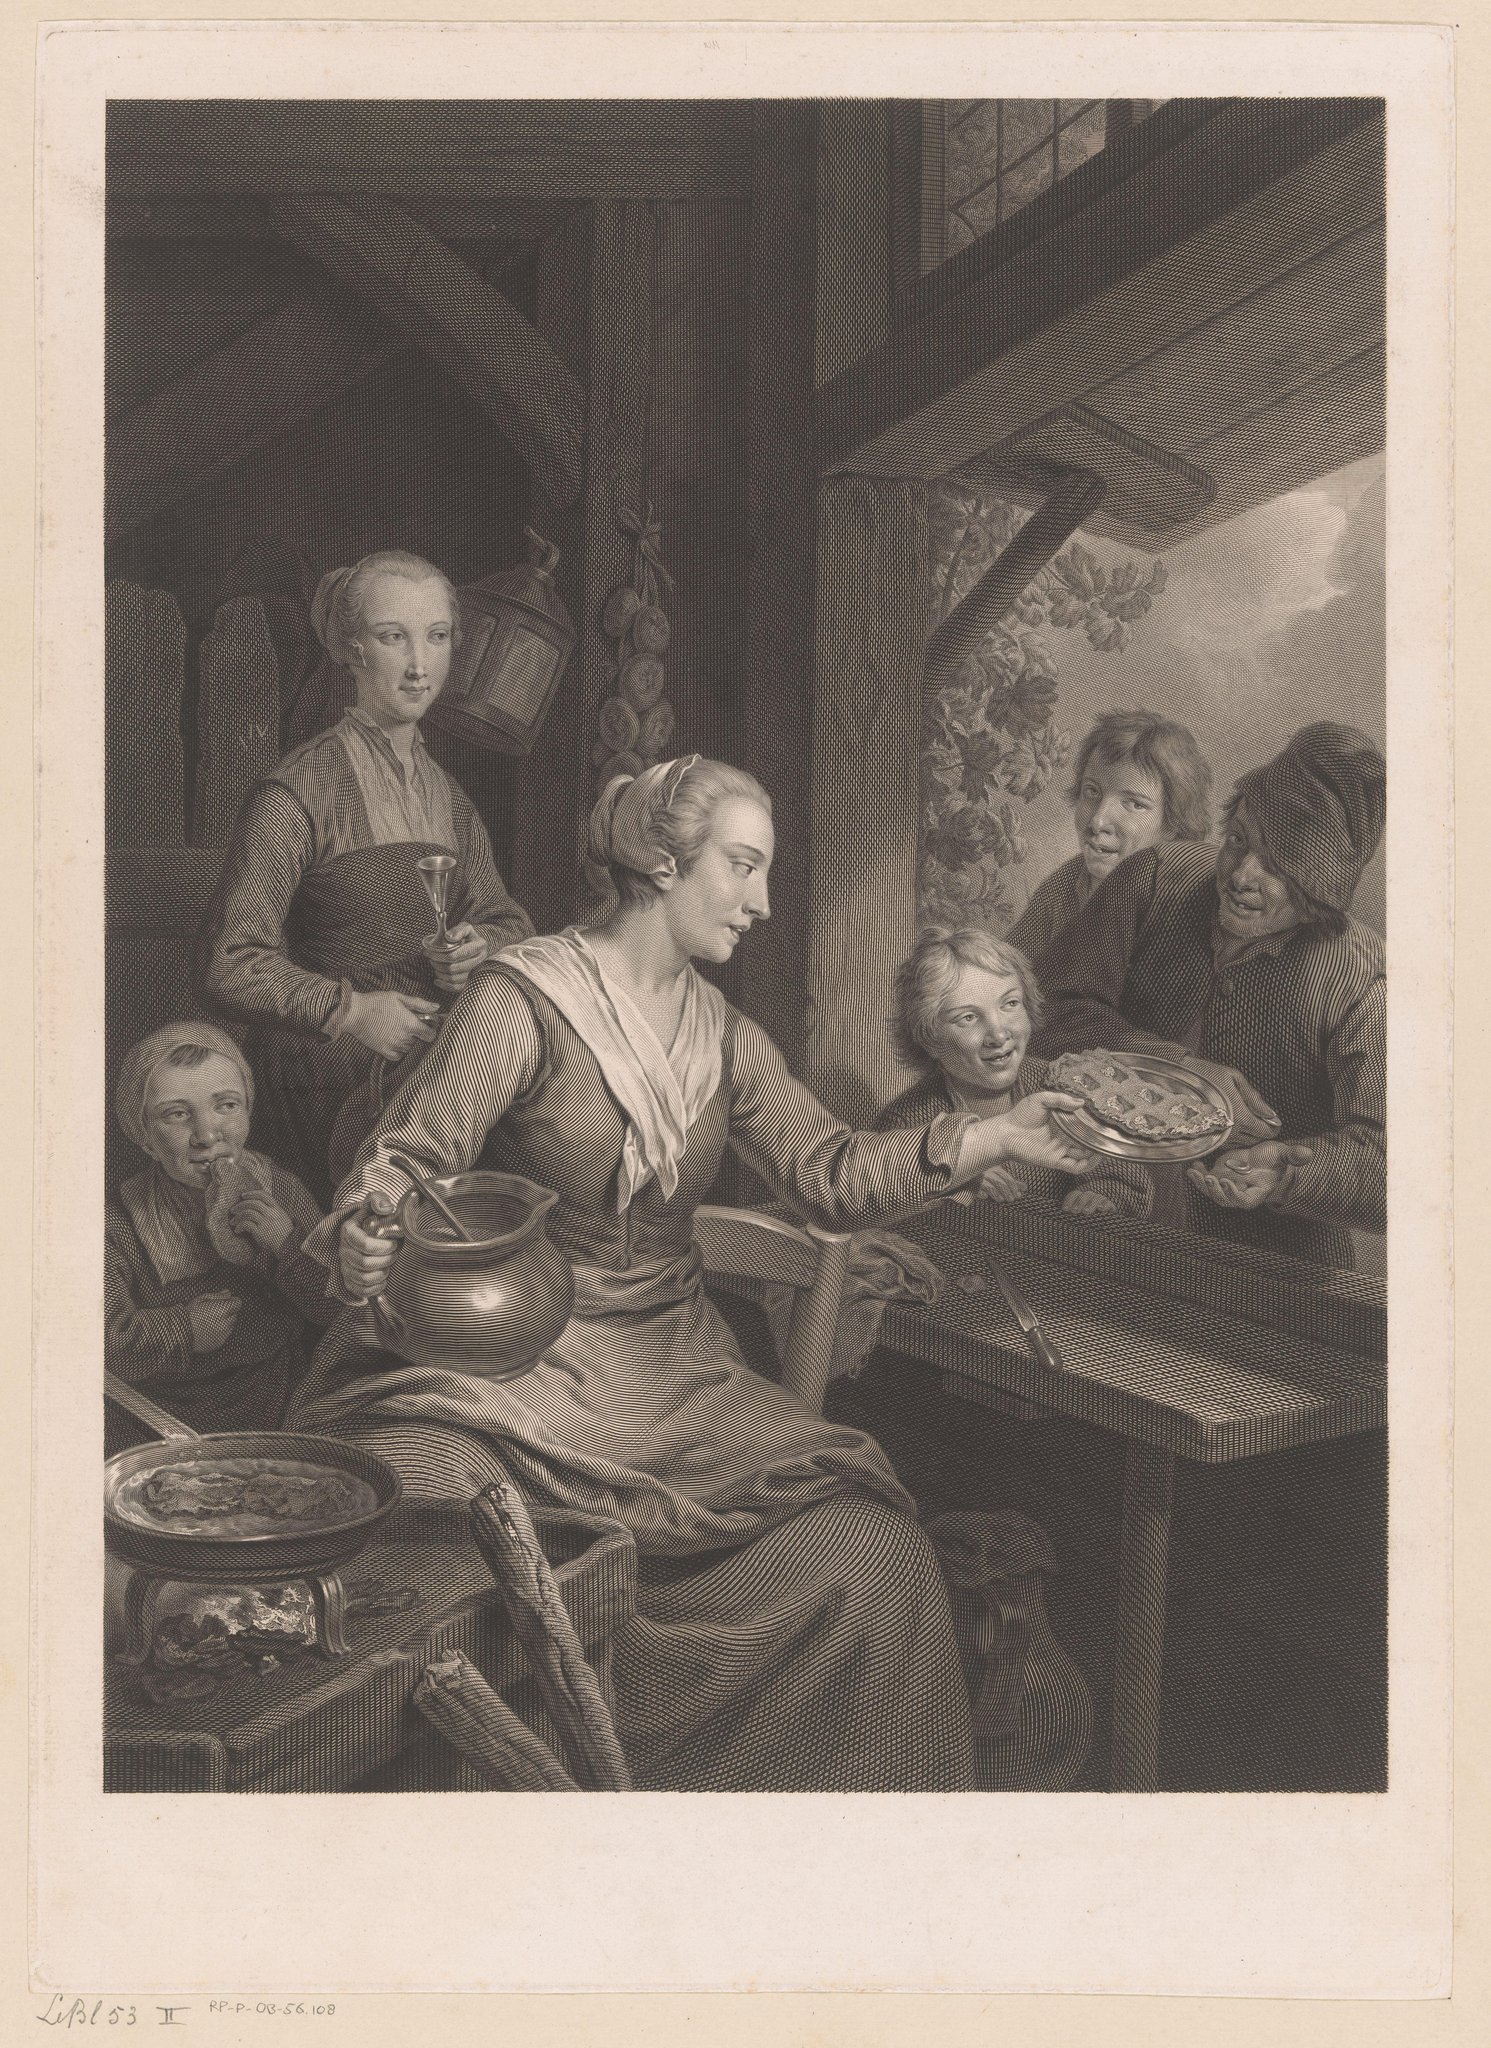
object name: print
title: Les offres réciproques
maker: johann georg wille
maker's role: draughtsman, print maker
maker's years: 1715-1808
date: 1771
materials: paper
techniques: engraving, etching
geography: paris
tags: cooking food, waffles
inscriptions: collector's mark: Lugt 240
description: Deze prent maakt deel uit van een serie van onbekende omvang naar Nederlandse en Duitse schilderijen. Op sommige prenten staat linksboven aangegeven welk nummer in de serie het betreft.